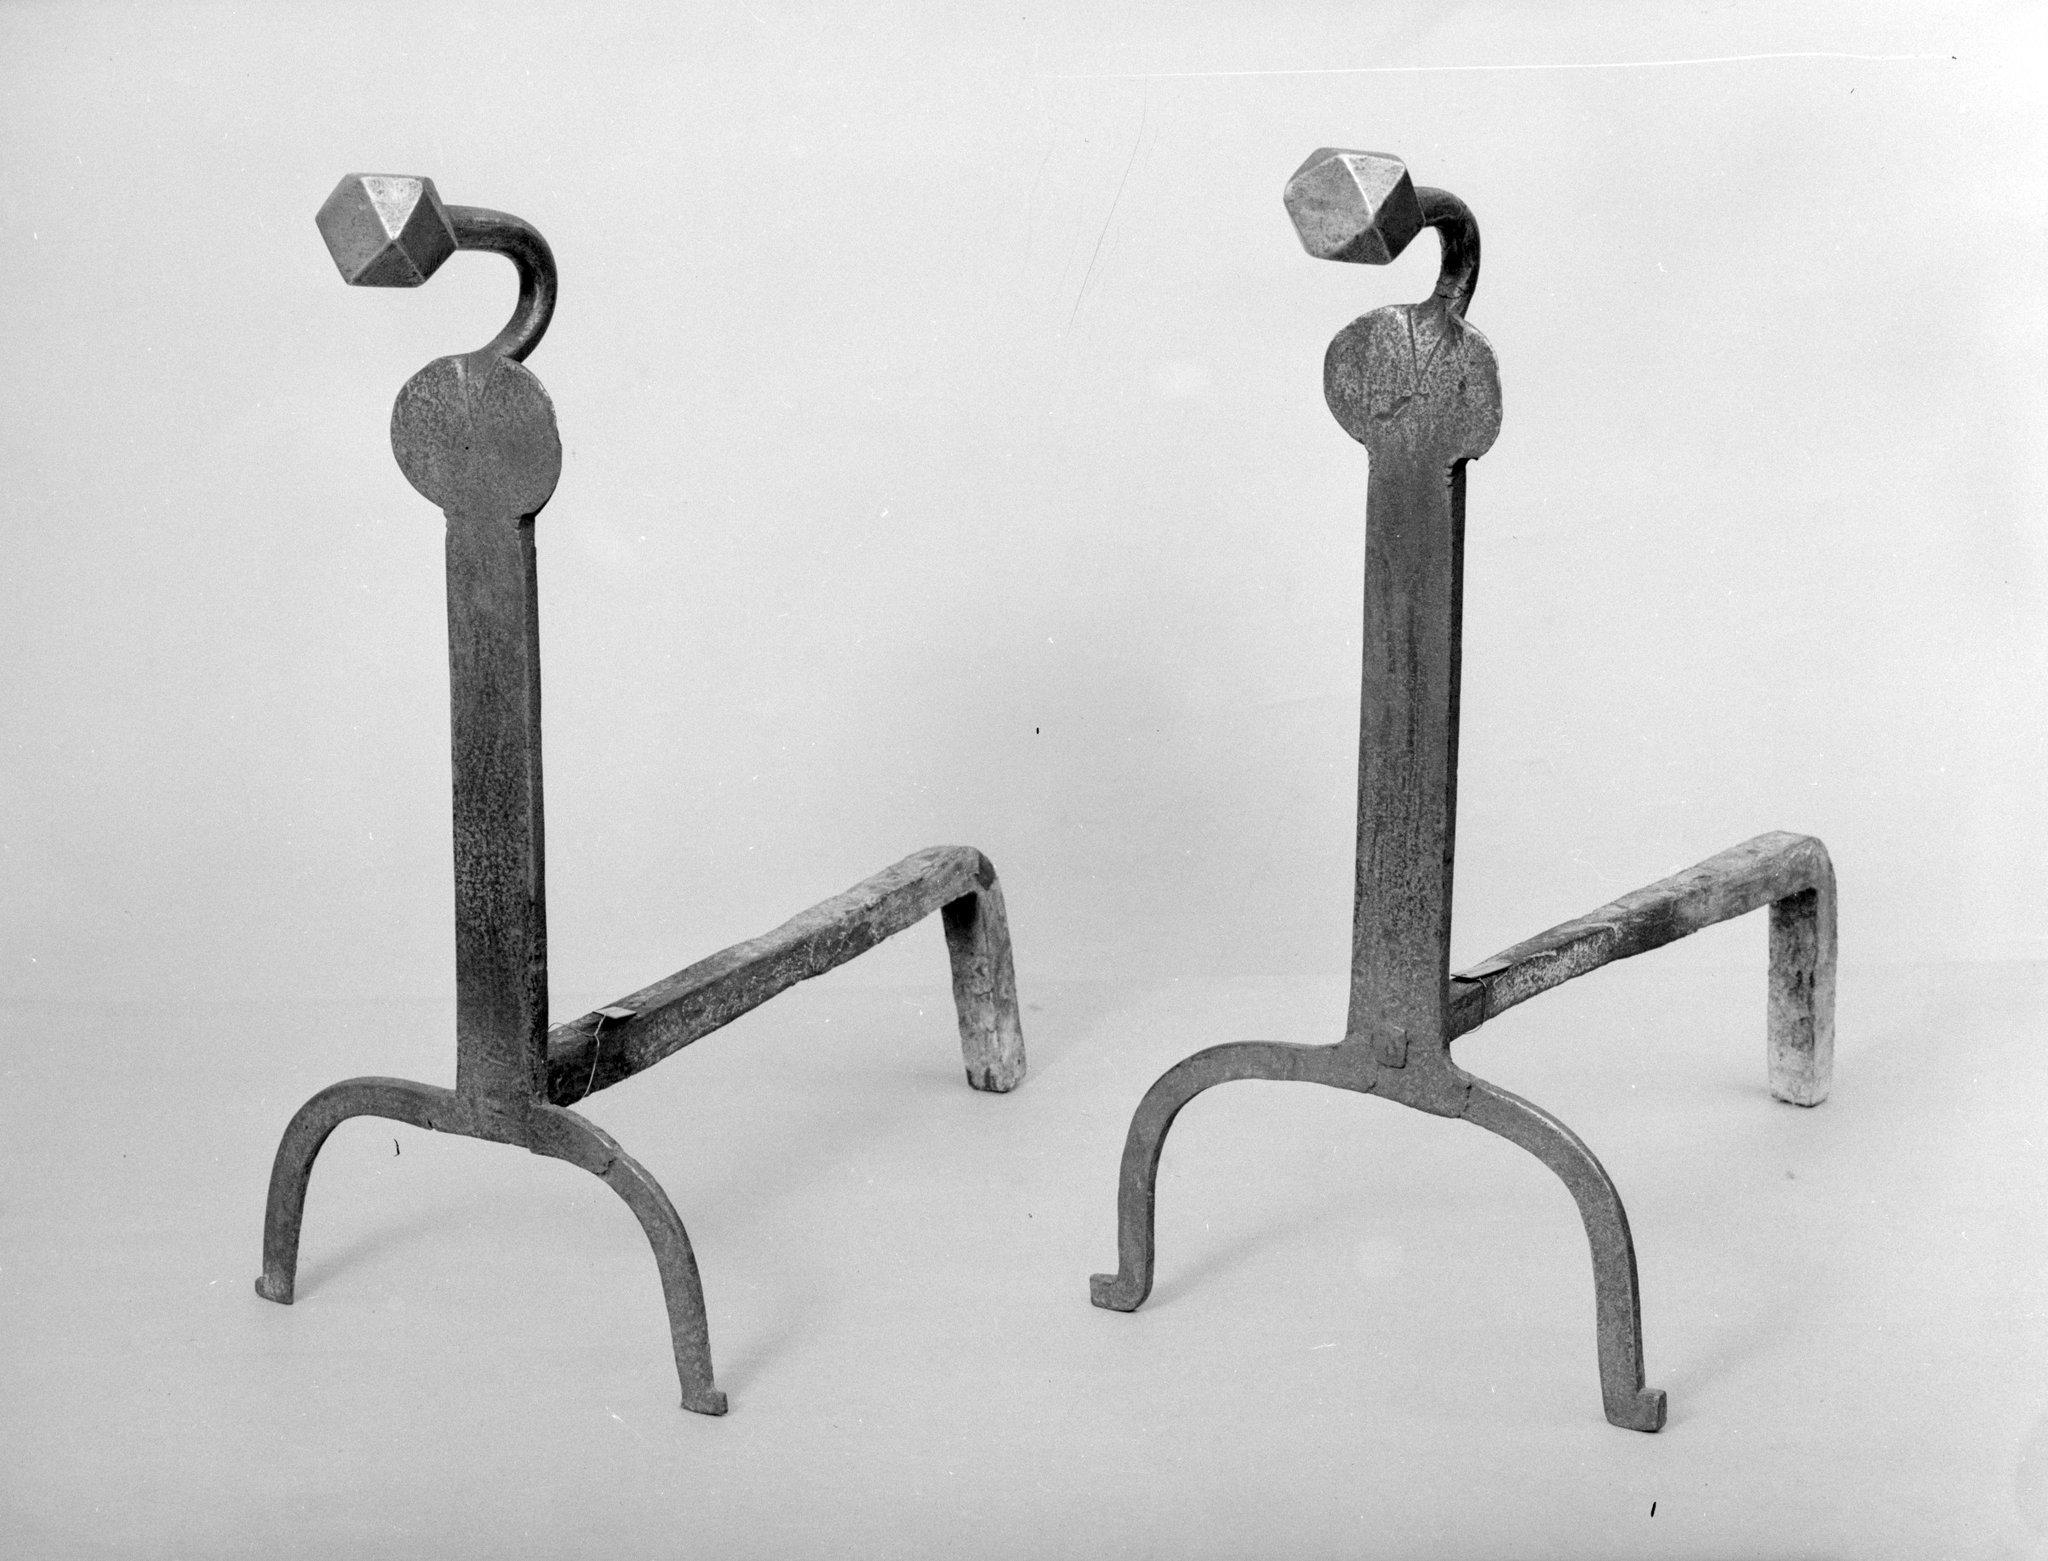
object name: andiron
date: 1700-1800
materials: iron